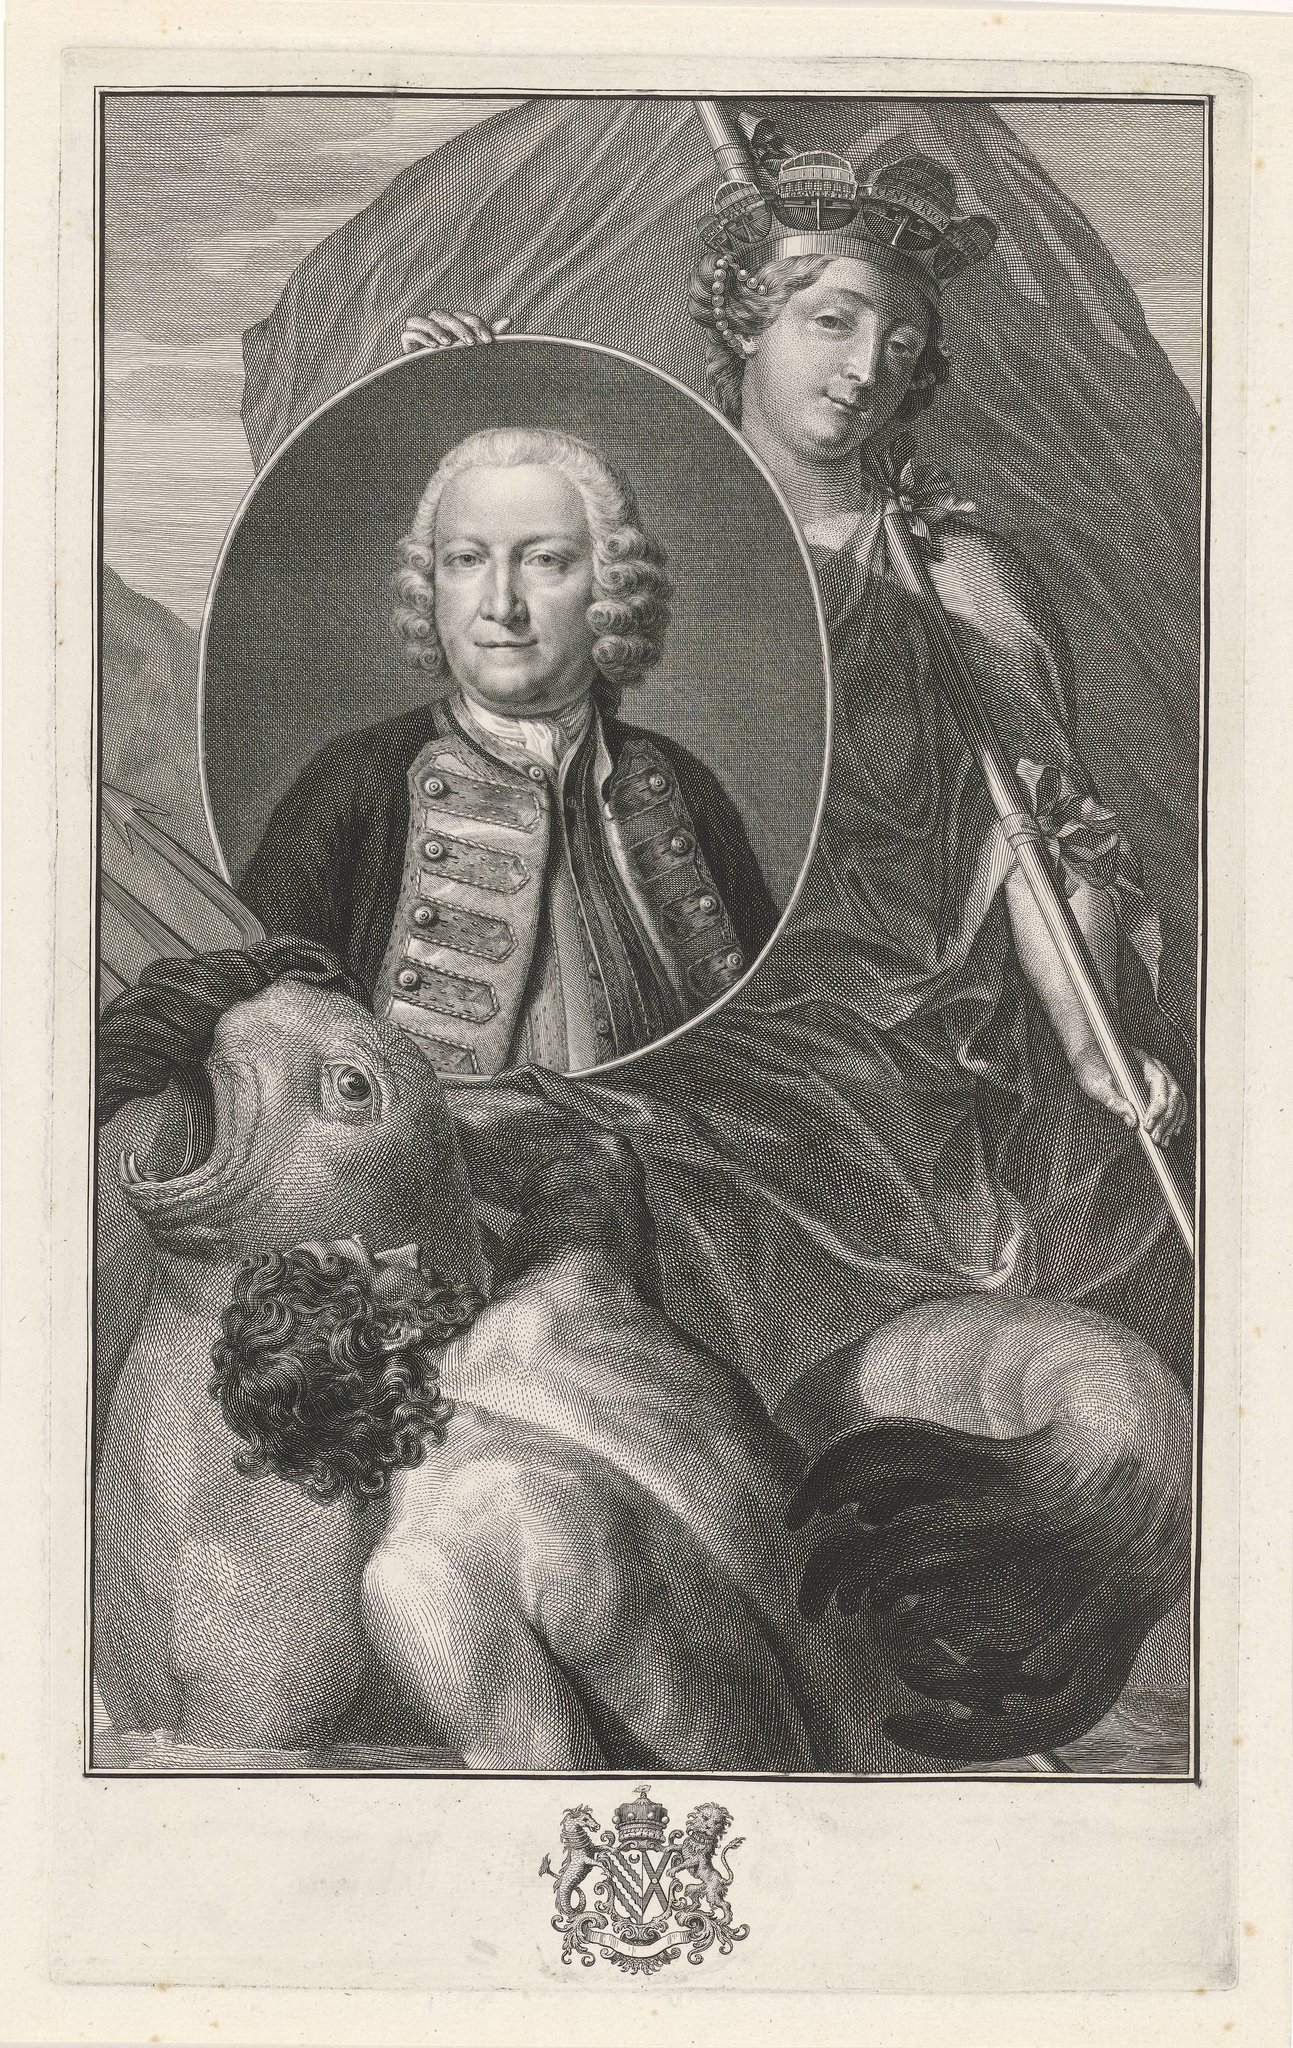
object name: print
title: Portret van George Anson met allegorische figuur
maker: jacob houbraken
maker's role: draughtsman, print maker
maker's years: 1698-1780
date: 1749-1751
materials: paper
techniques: engraving, etching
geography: amsterdam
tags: banner, standard (as symbol of the state, etc.), attributes of neptune: trident, swimming mammals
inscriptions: collector's mark: Lugt 240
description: Portret van George Anson in een ovaal, dat wordt vastgehouden door een allegorische figuur, die de Engelse vlag vasthoudt en op haar hoofd een kroon van oorlogsschepen draagt. Op de voorgrond een zeeleeuw en een mannelijk figuur met een drietand; Neptunus of de personificatie van het element water. Onder het portret het wapen van de geportretteerde.